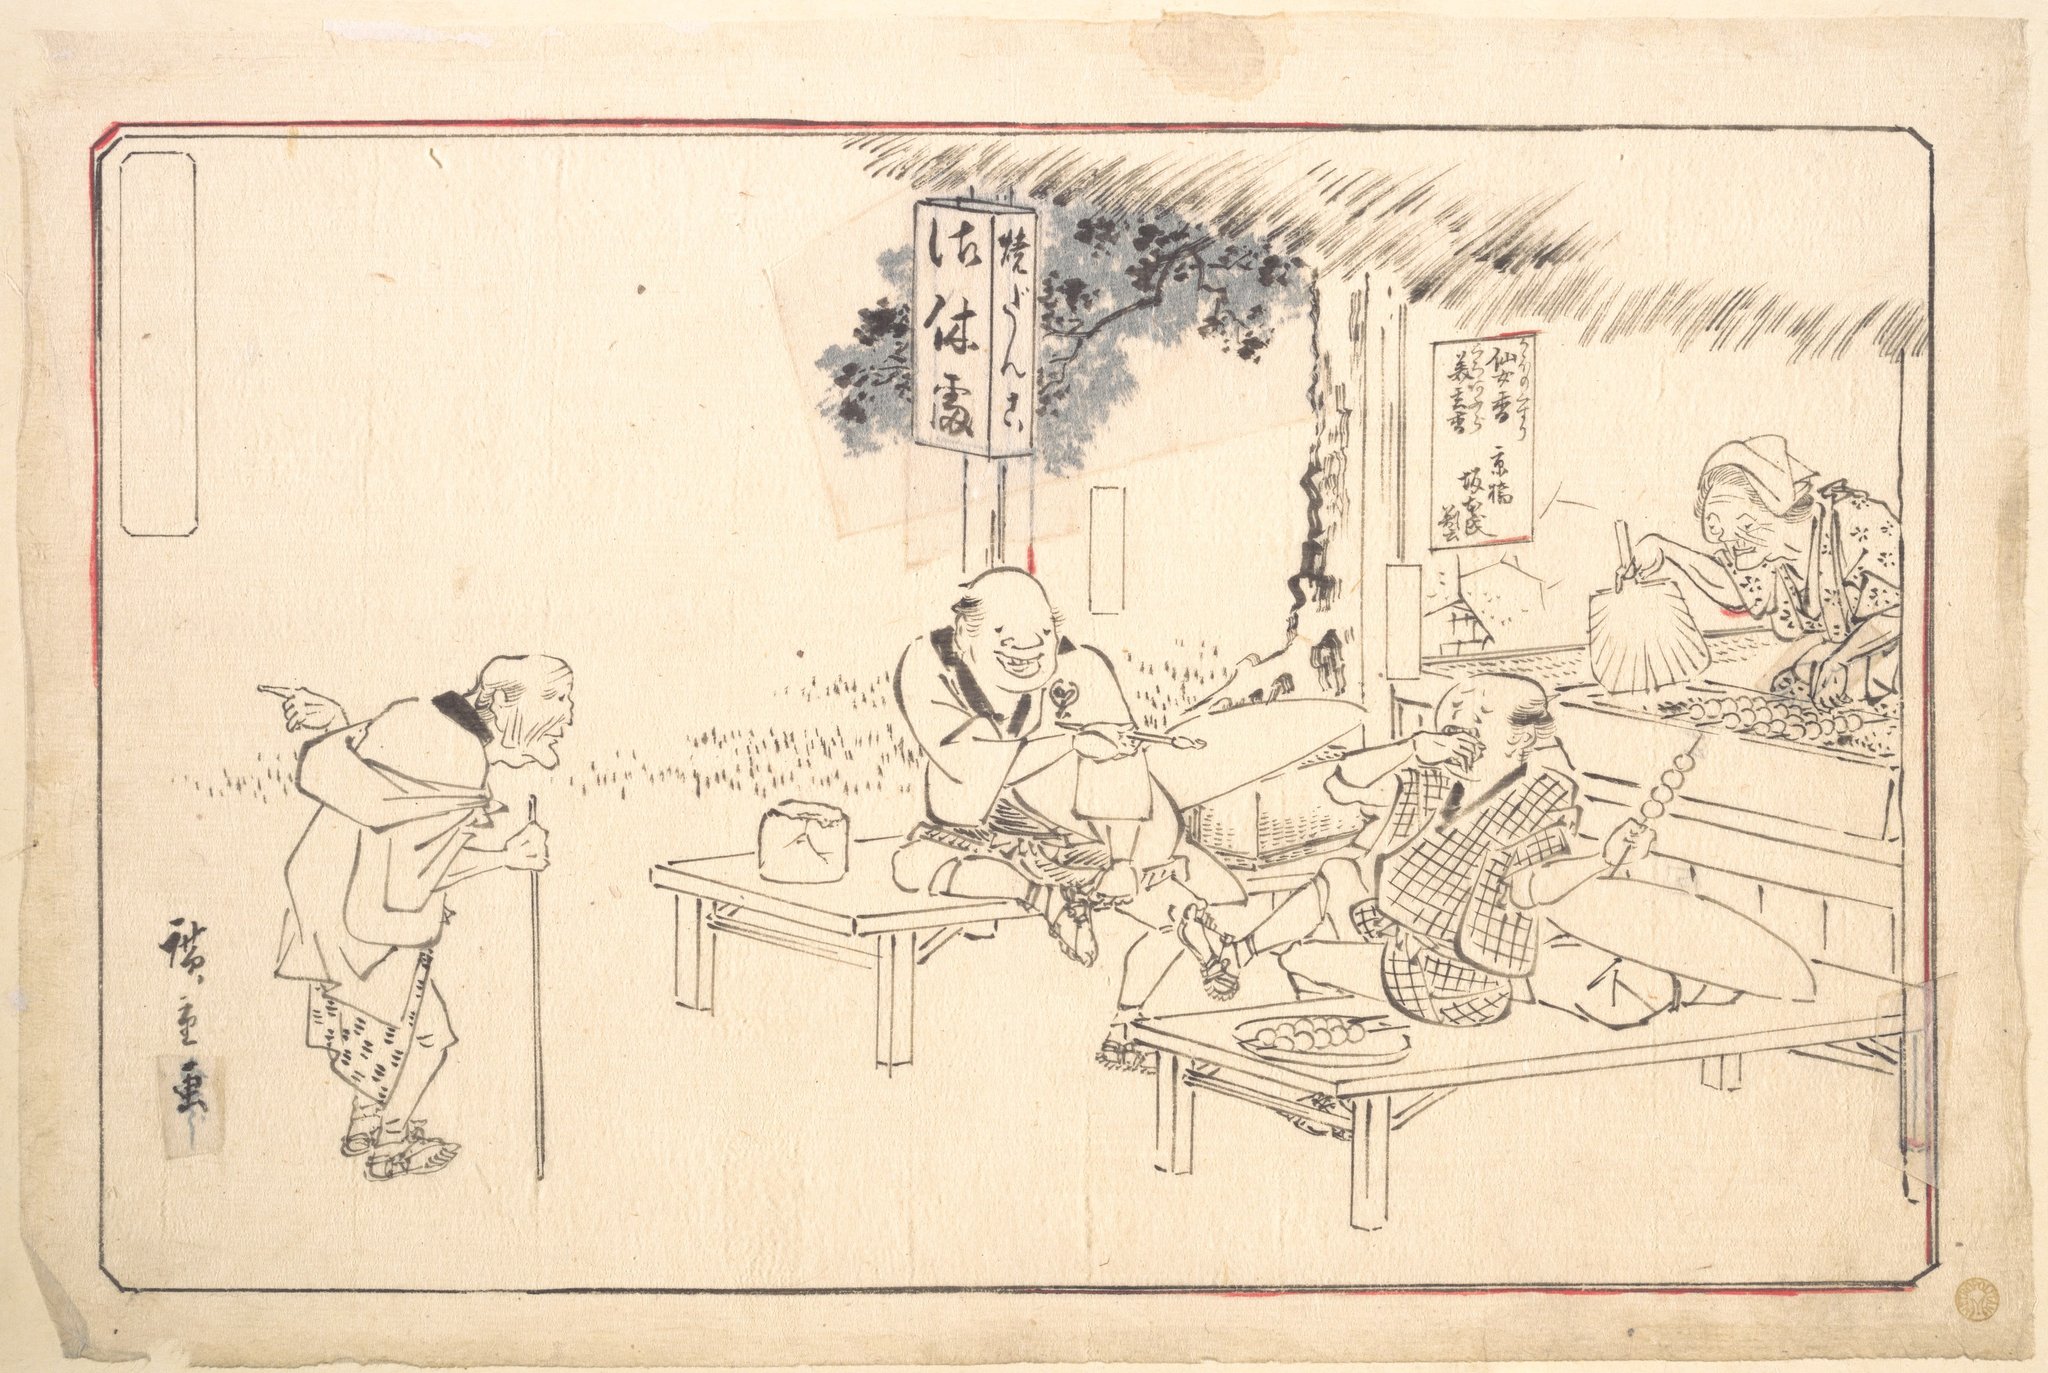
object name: woodblock print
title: The Famous Practical Jokers Yajirobei at a Wayside Restaurant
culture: japanese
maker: utagawa hiroshige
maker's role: artist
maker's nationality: japanese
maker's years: 1797-1858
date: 1840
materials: ink, paper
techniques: woodblock print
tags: food,restaurants,men,women